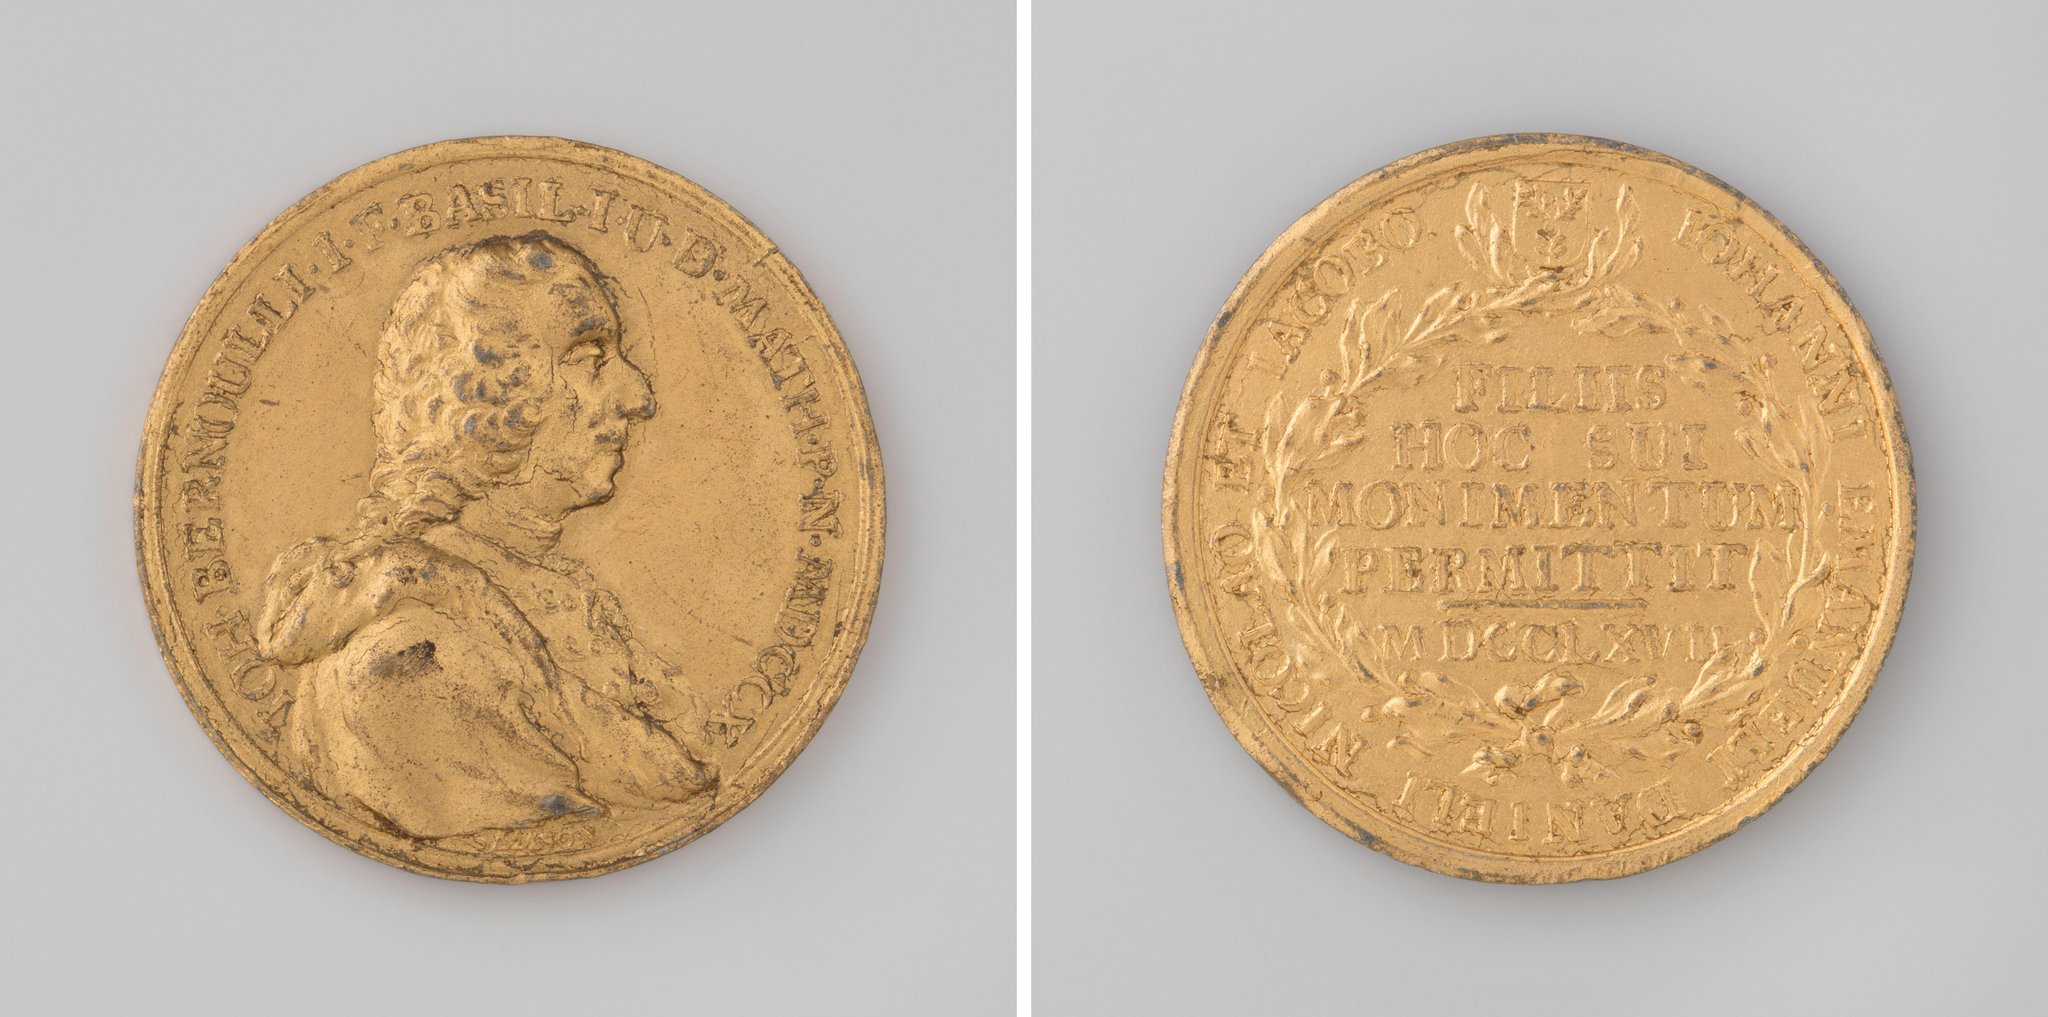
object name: history medal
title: Johannes Bernouilli, wiskundige te Basel, penning geslagen op last van zijn vijf zonen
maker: johann ulrich samson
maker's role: medailleur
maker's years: 1729-1806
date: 1767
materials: silver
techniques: gilding, striking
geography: basel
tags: johan bernouilli (1710-1790), bazel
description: Zilveren penning. Voorzijde: borststuk man binnen omschrift. Keerzijde: opschrift binnen bladerkrans en omschrift, onderbroken door wapenschild